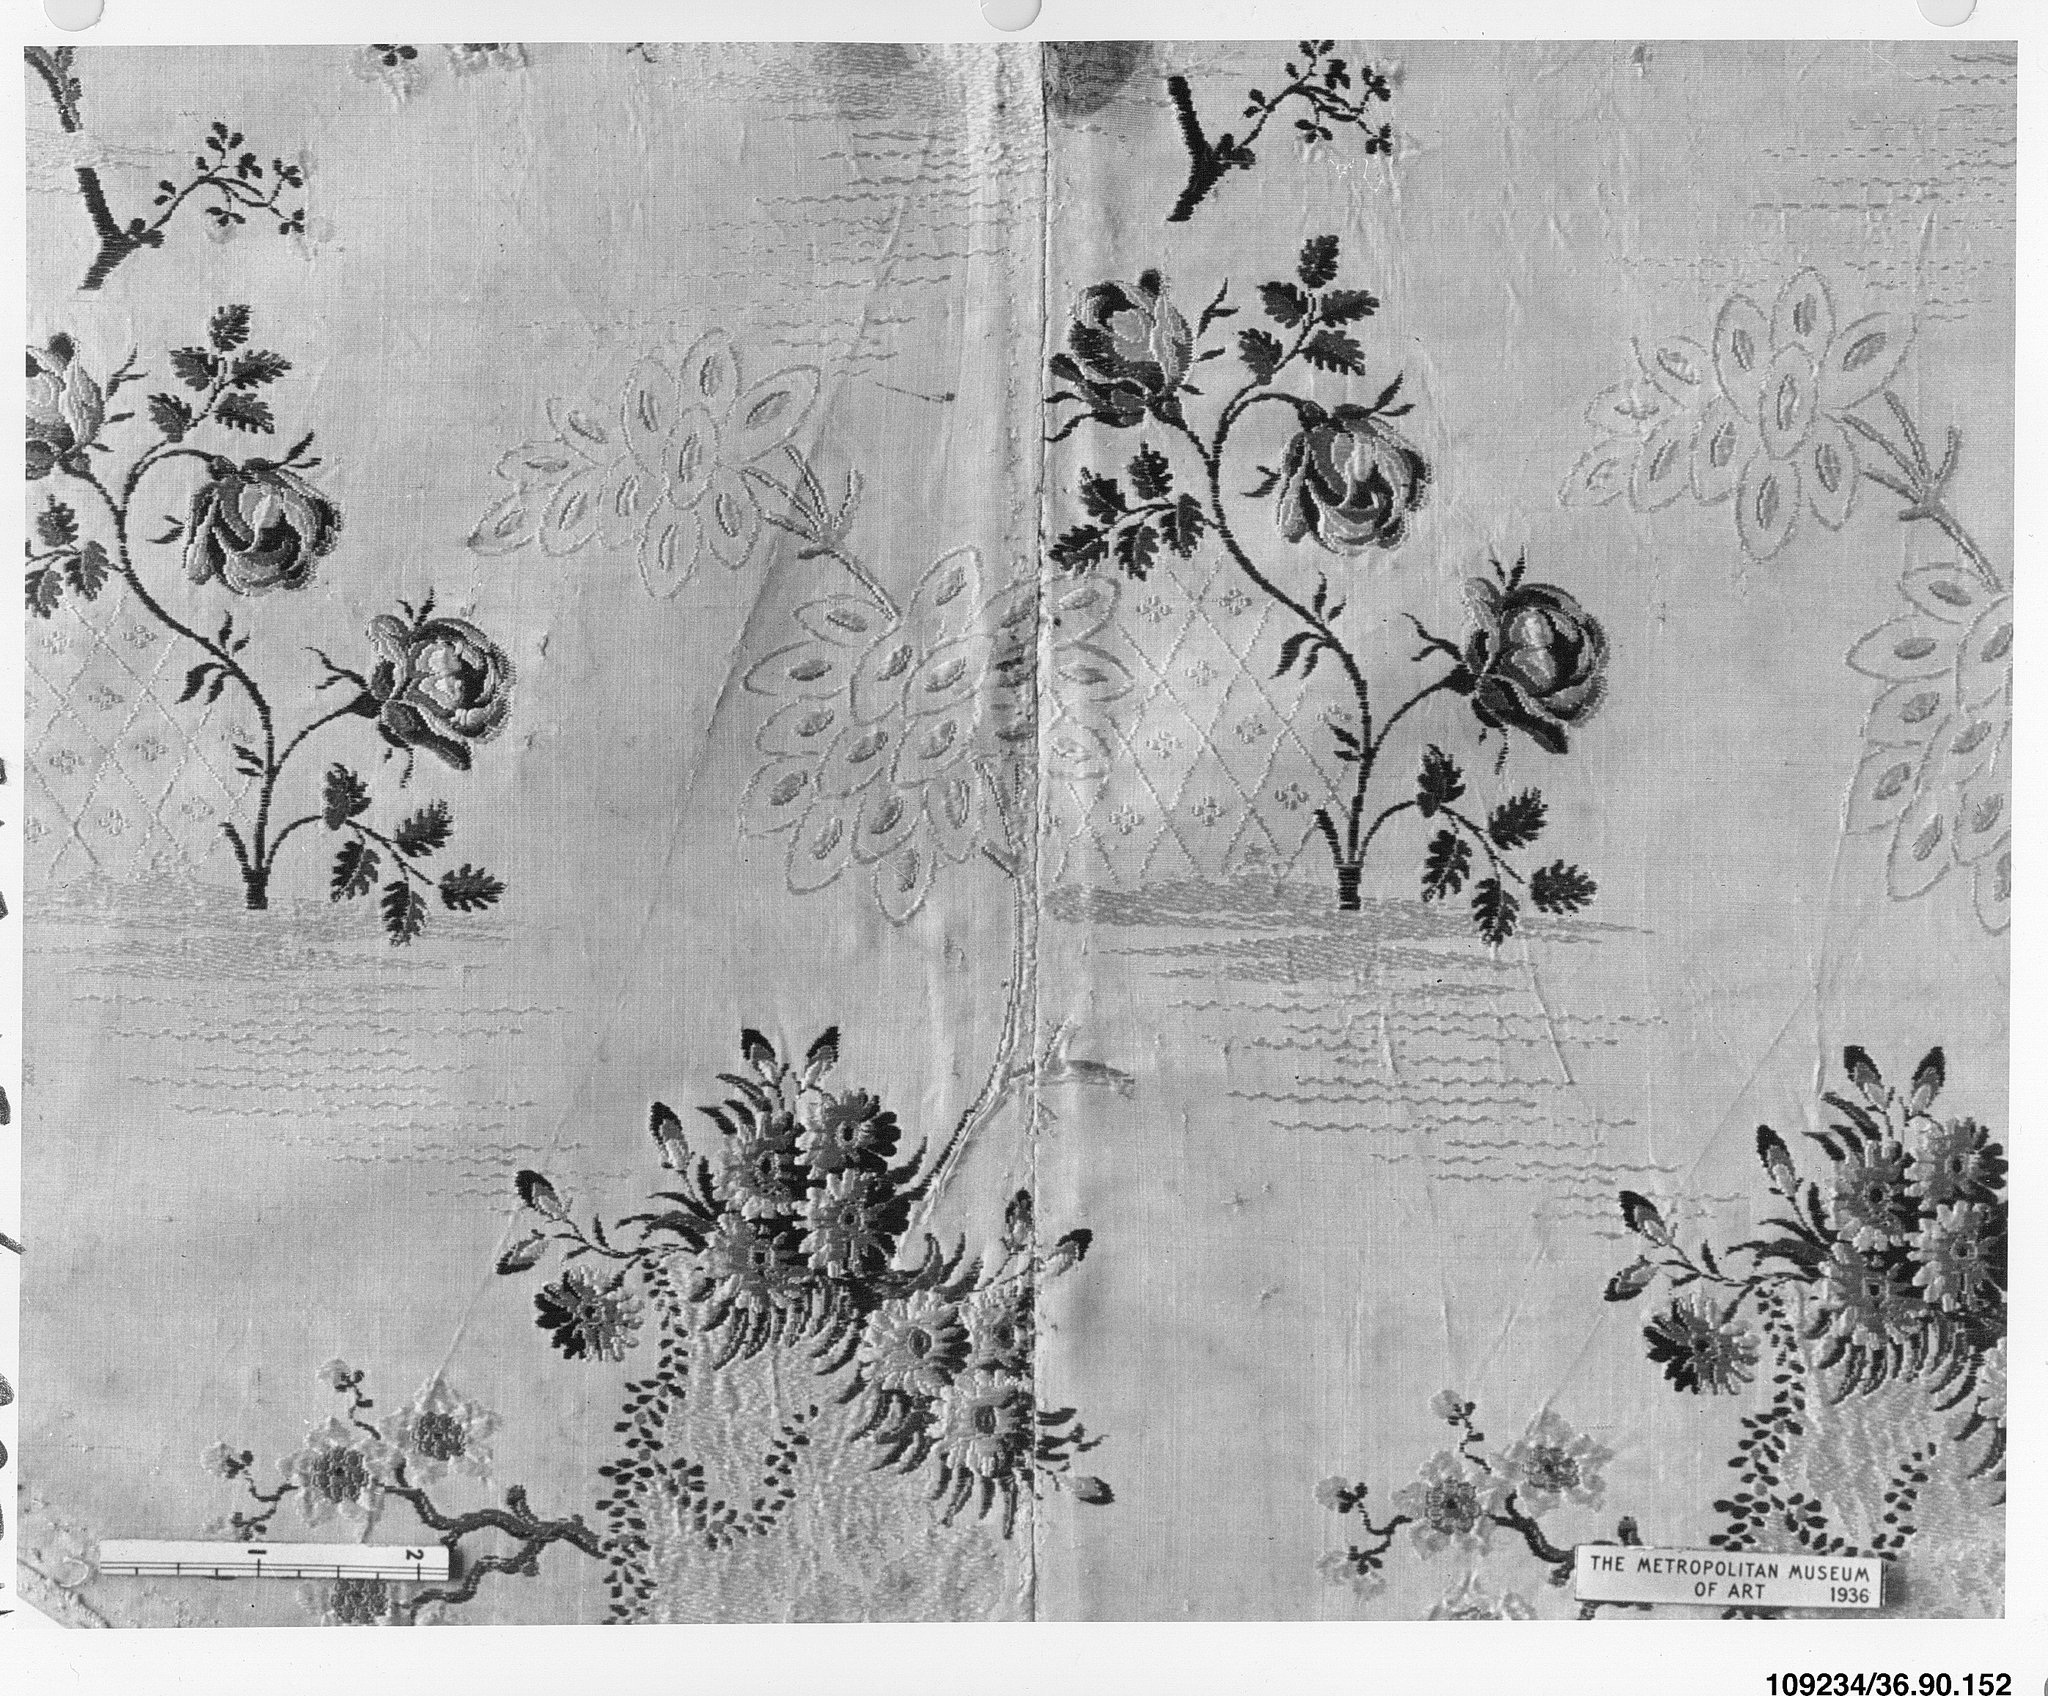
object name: piece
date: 1750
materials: silk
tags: flowers,leaves